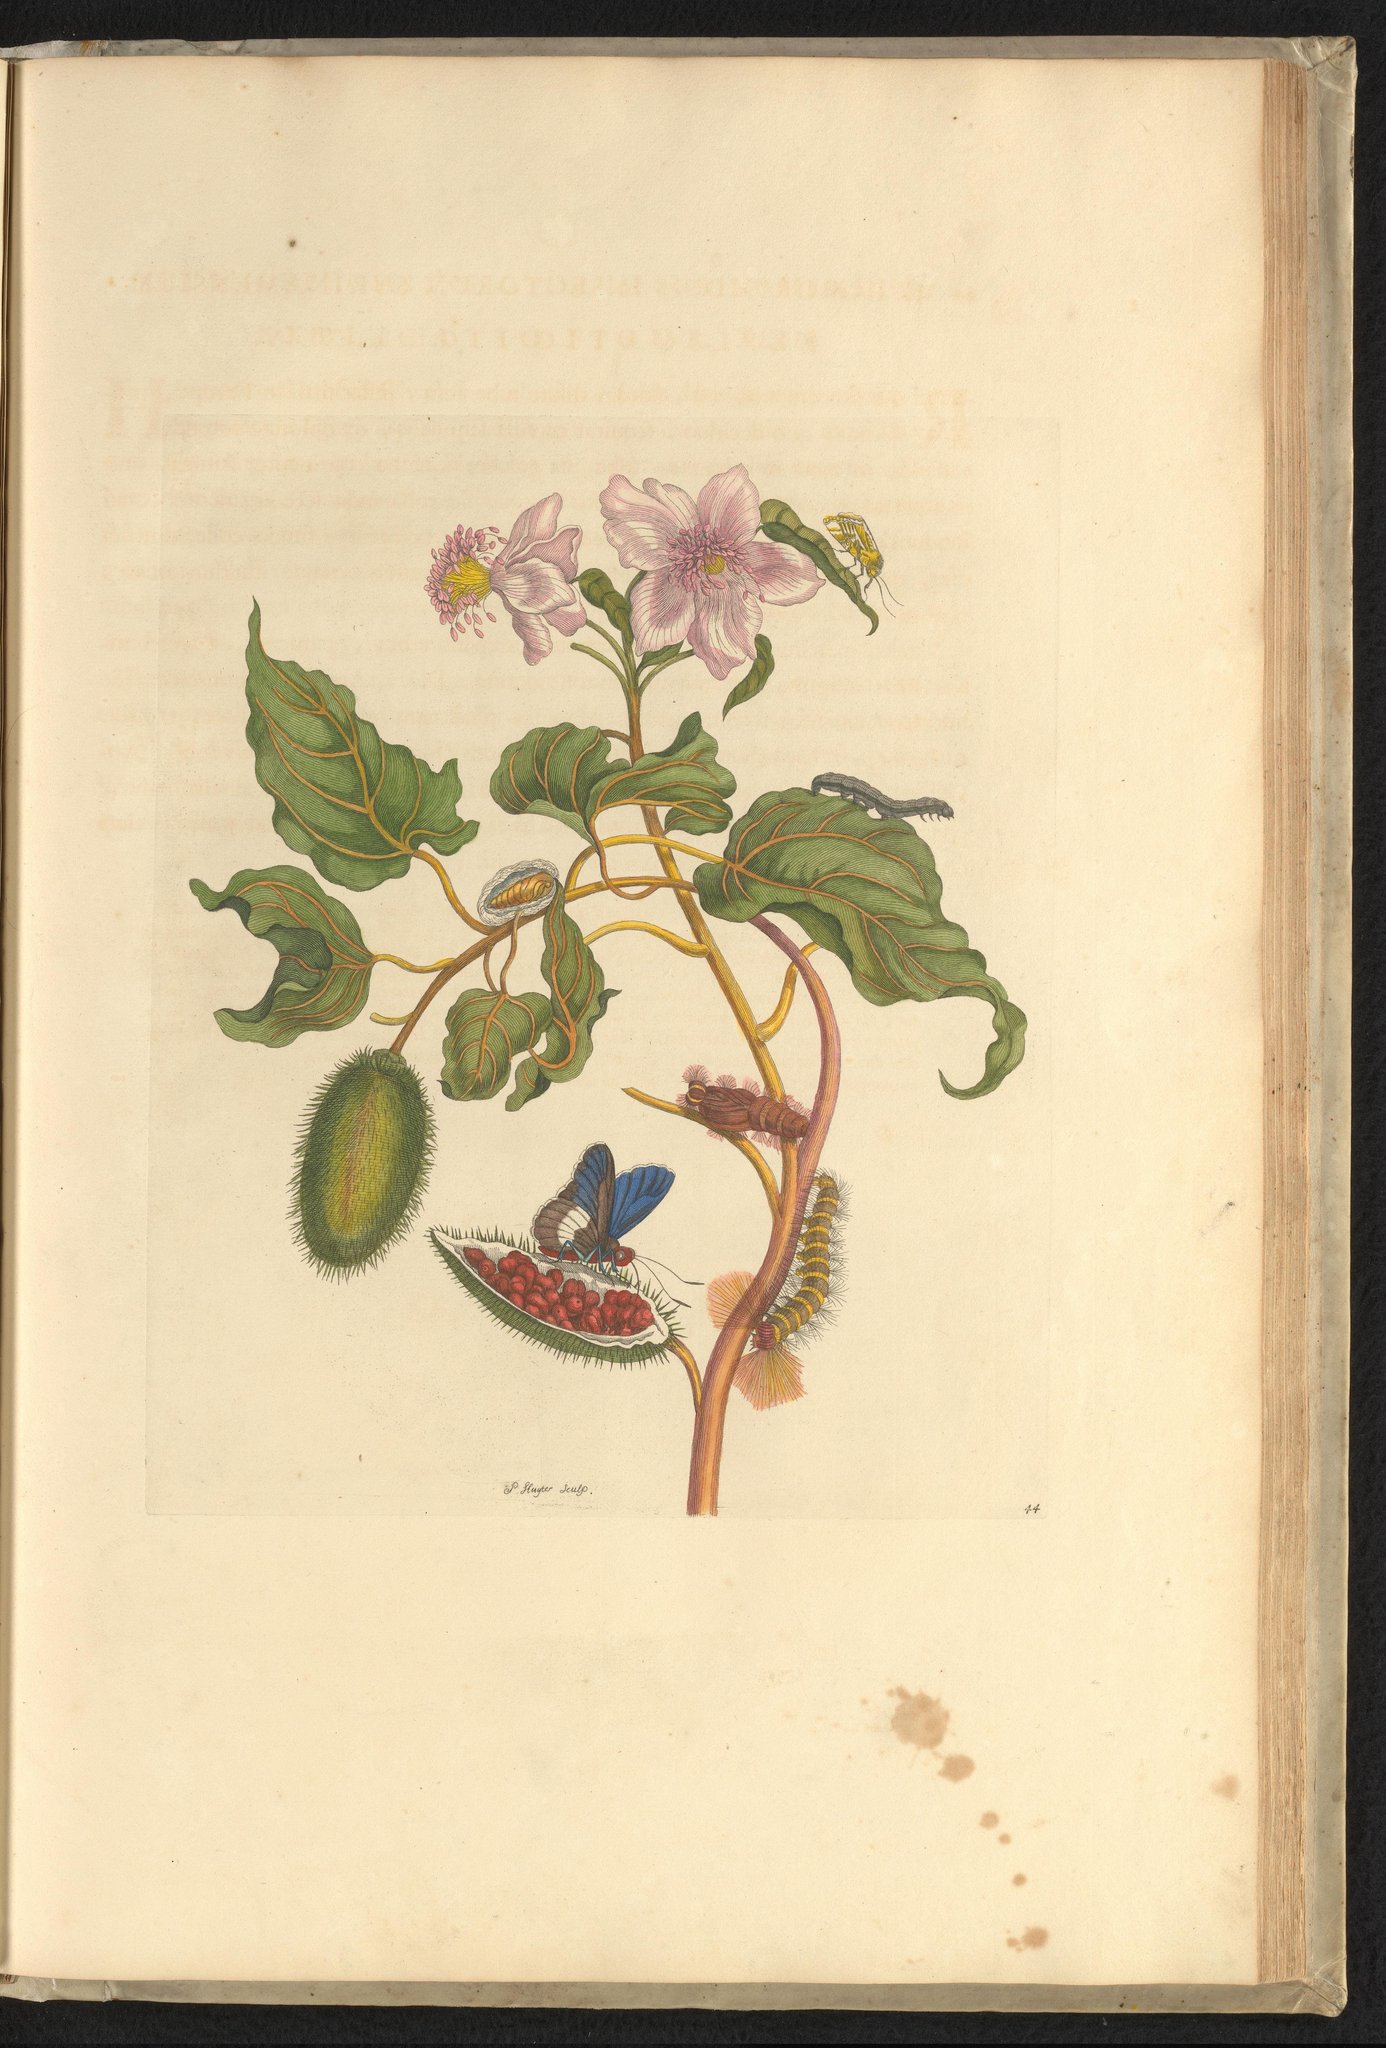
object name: print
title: Orleaanboom (Bixa orellana) met vlinder, nachtvlinder, rupsen en poppen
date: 1705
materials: paper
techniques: etching, hand coloring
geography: suriname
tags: flowers, trees, insects: pupa, insects: moth, insects: butterfly, insects: caterpillar, suriname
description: Rechtsonder genummerd: 44. Prent maakt deel uit van een boek.